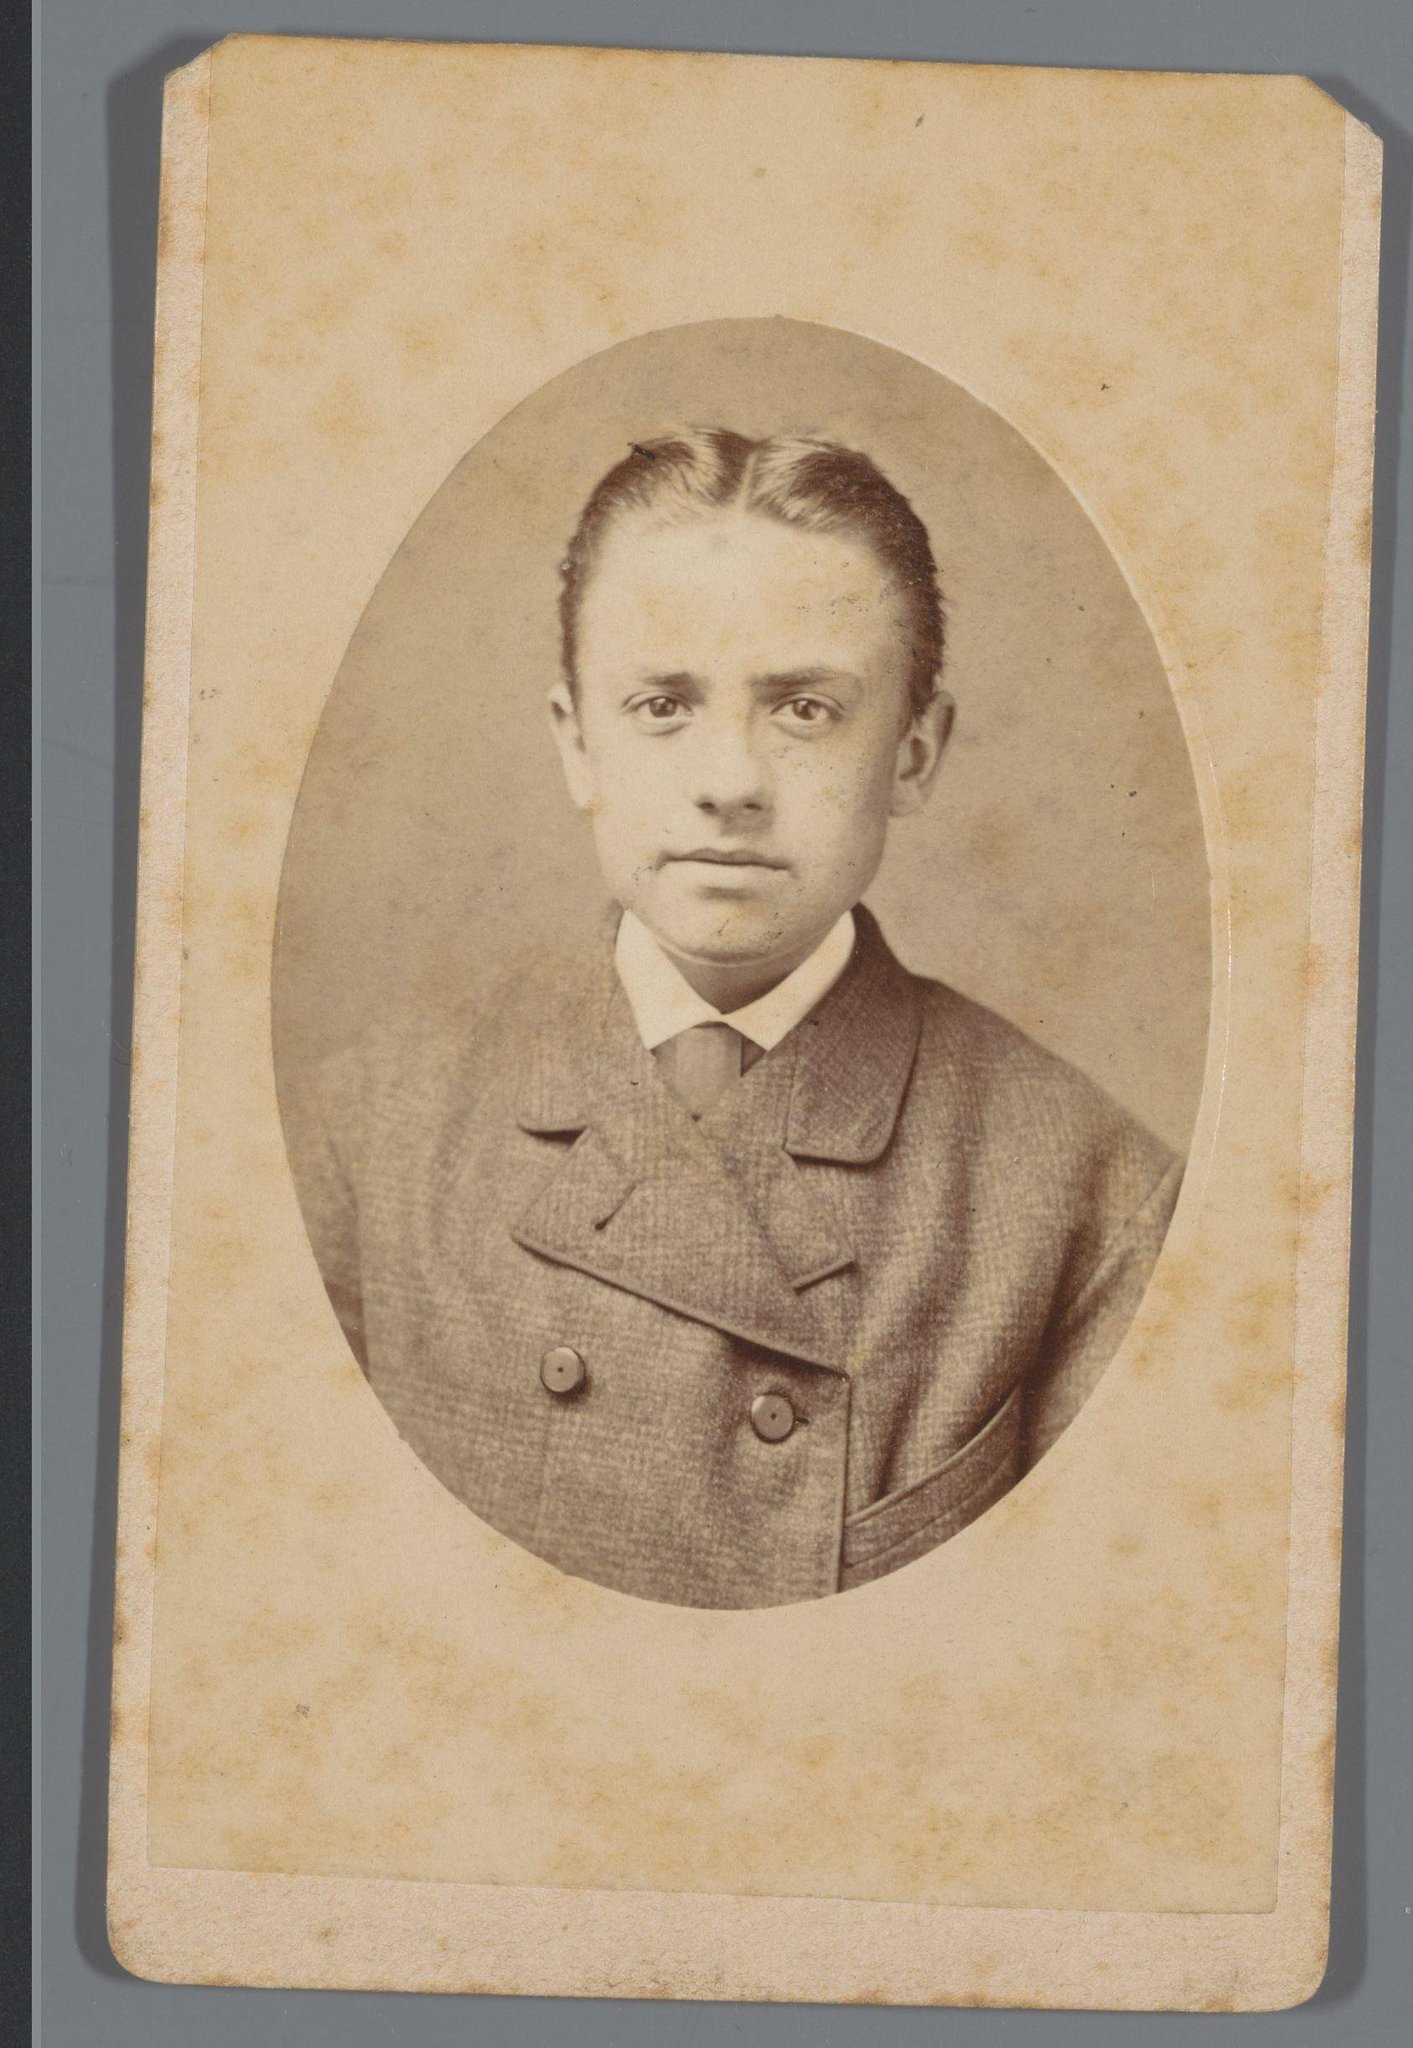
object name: carte de visite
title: Portret van een onbekende man, aangeduid als de heer J. de Weeger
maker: jan george mulder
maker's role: fotograaf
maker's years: 1816-1895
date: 1875-1885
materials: cardboard, paper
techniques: albumen print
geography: utrecht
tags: historical persons, youth, adolescent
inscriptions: inscription: ‘PHOTOGRAPISCH/ ATELIER/ No. 12./ F. G. Mulder/ Lange Begijnestraat/ over de / Israëlitische Kerk./ HAARLEM.’, inscription: ‘J. de Weeger/ geb. 10-5-1862/ + 17-7-1930’